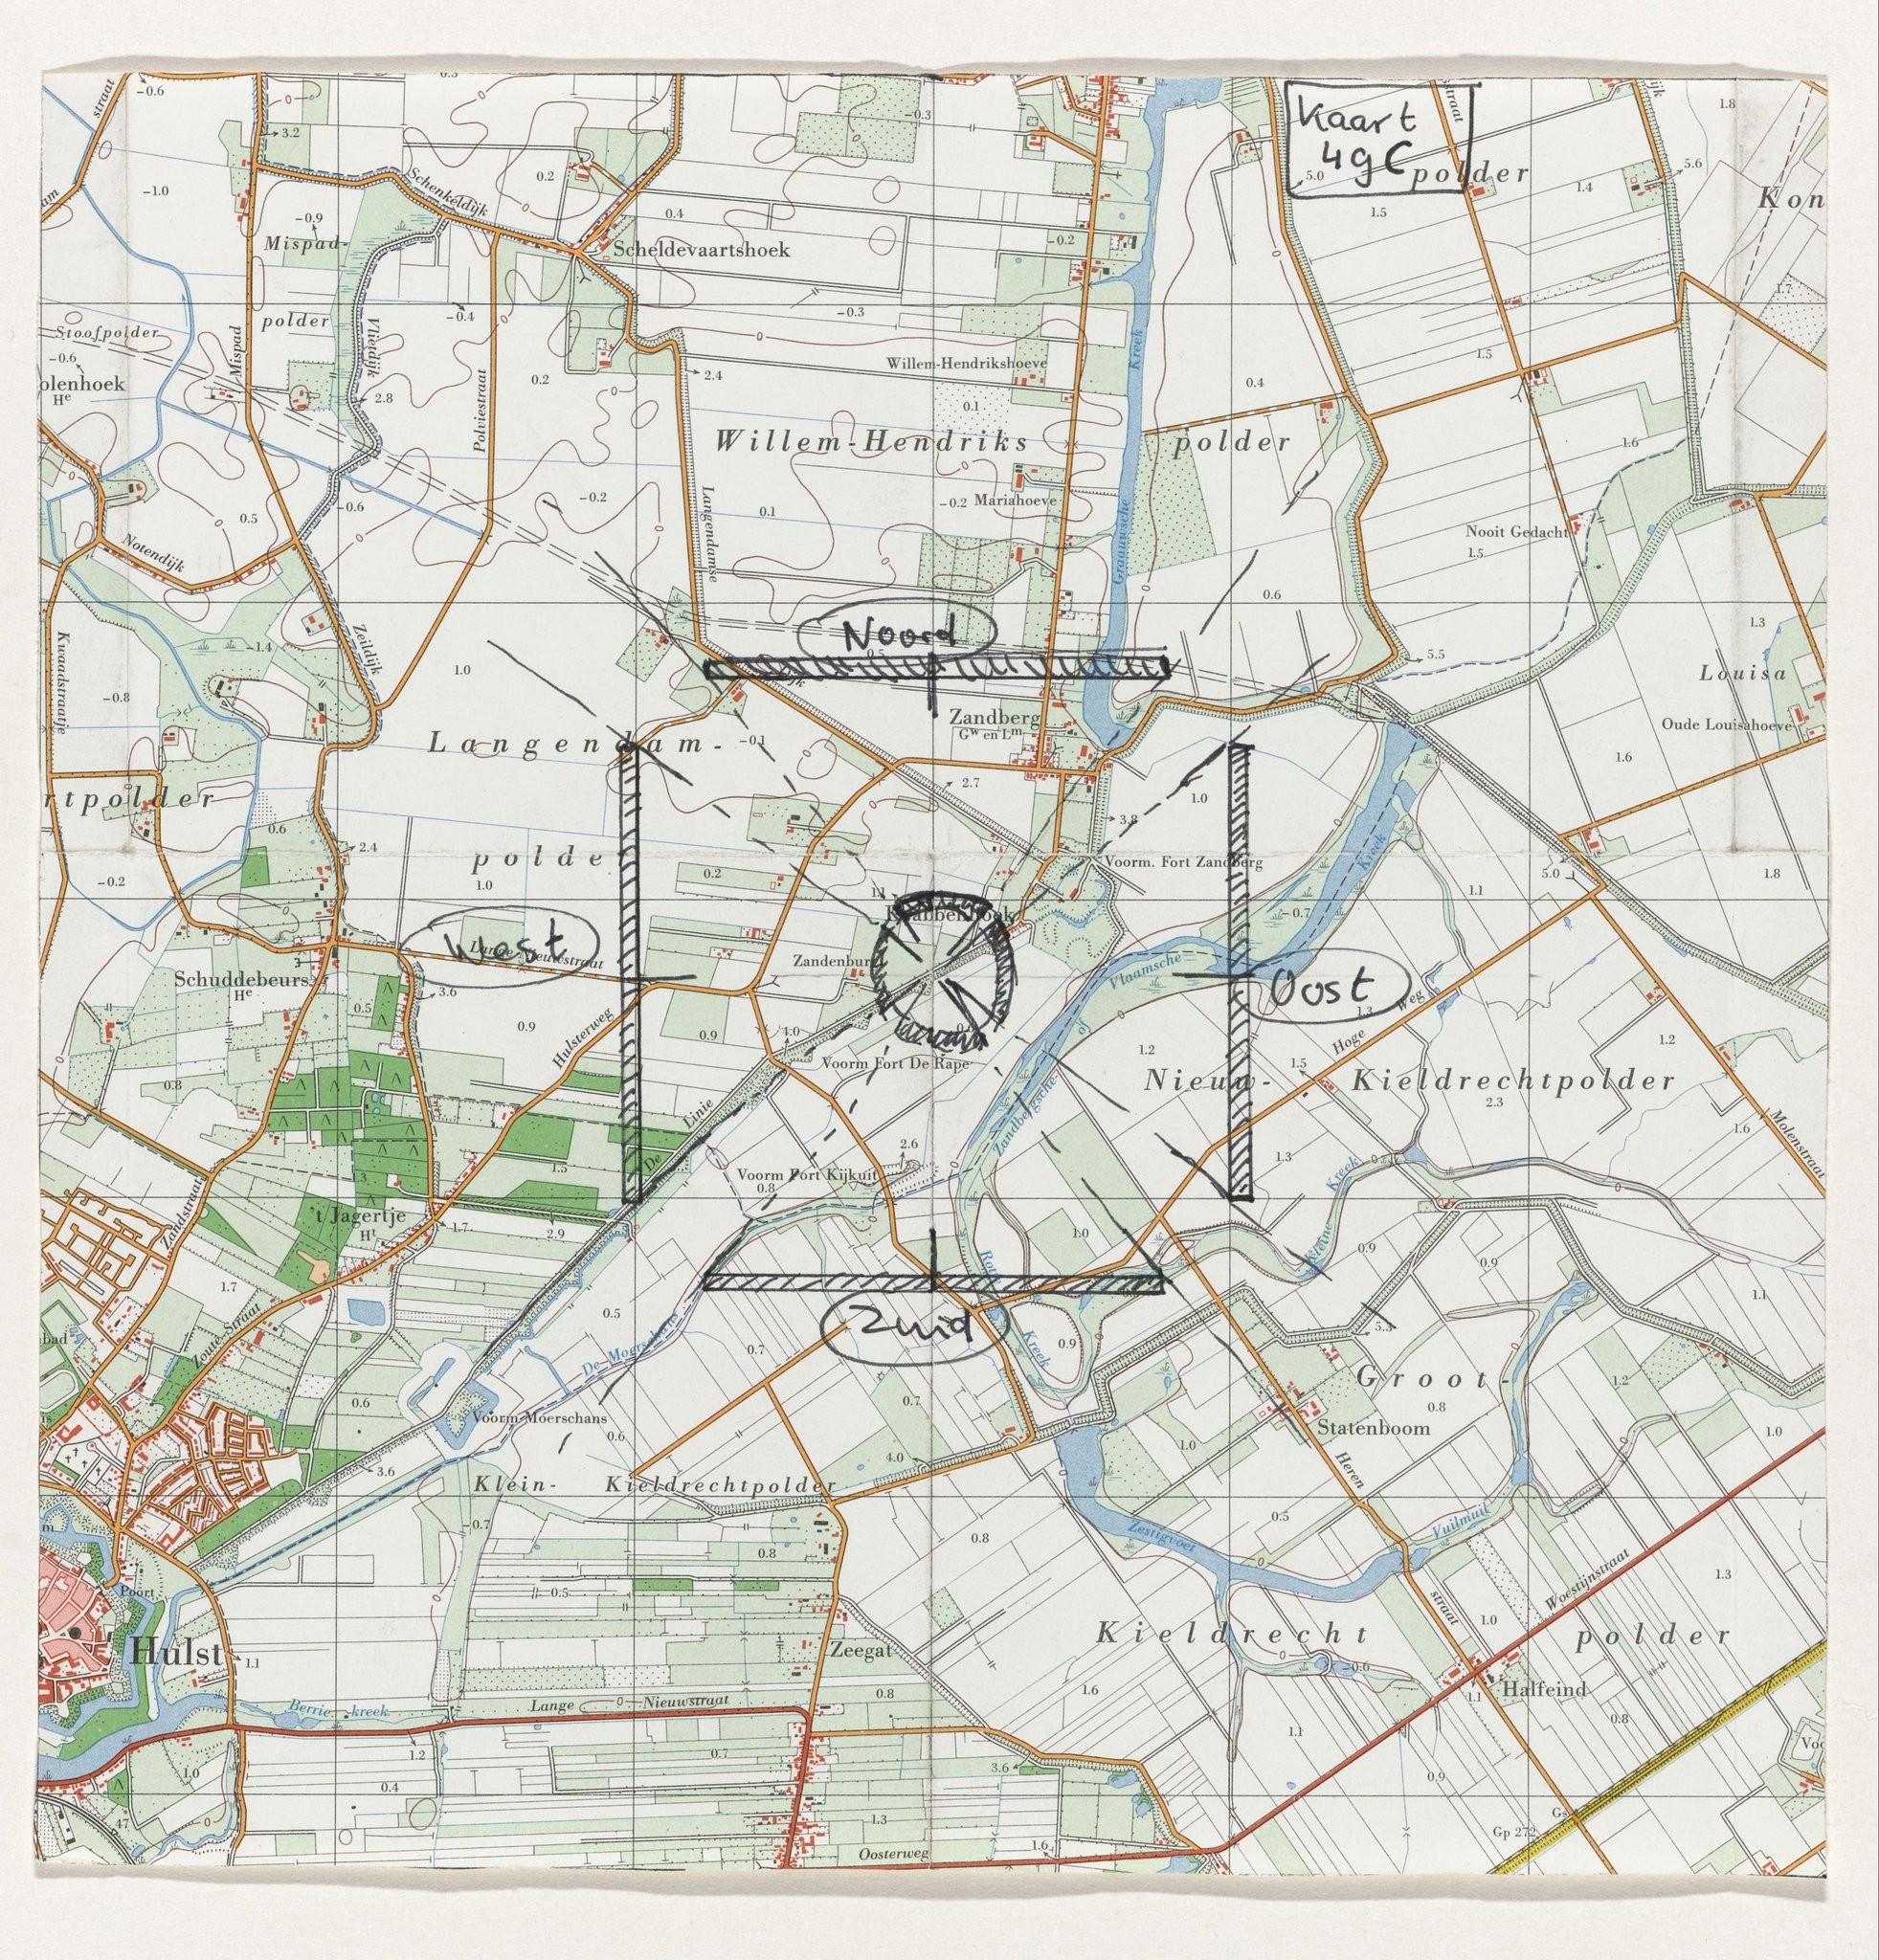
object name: map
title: Fragment of Topographic Map Hulst 55 A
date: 1945-1975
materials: paper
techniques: printing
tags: hulst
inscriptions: inscription: ‘kaart 49C’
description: Mulder pressed this system into service to find his way to the centre point of a specific topographic map. There, photographs were to be taken from all four points of the compass. On this fragment of topographic map Hulst 55 A Mulder drew his camera angle, with each section of land around it that he recorded per shot.